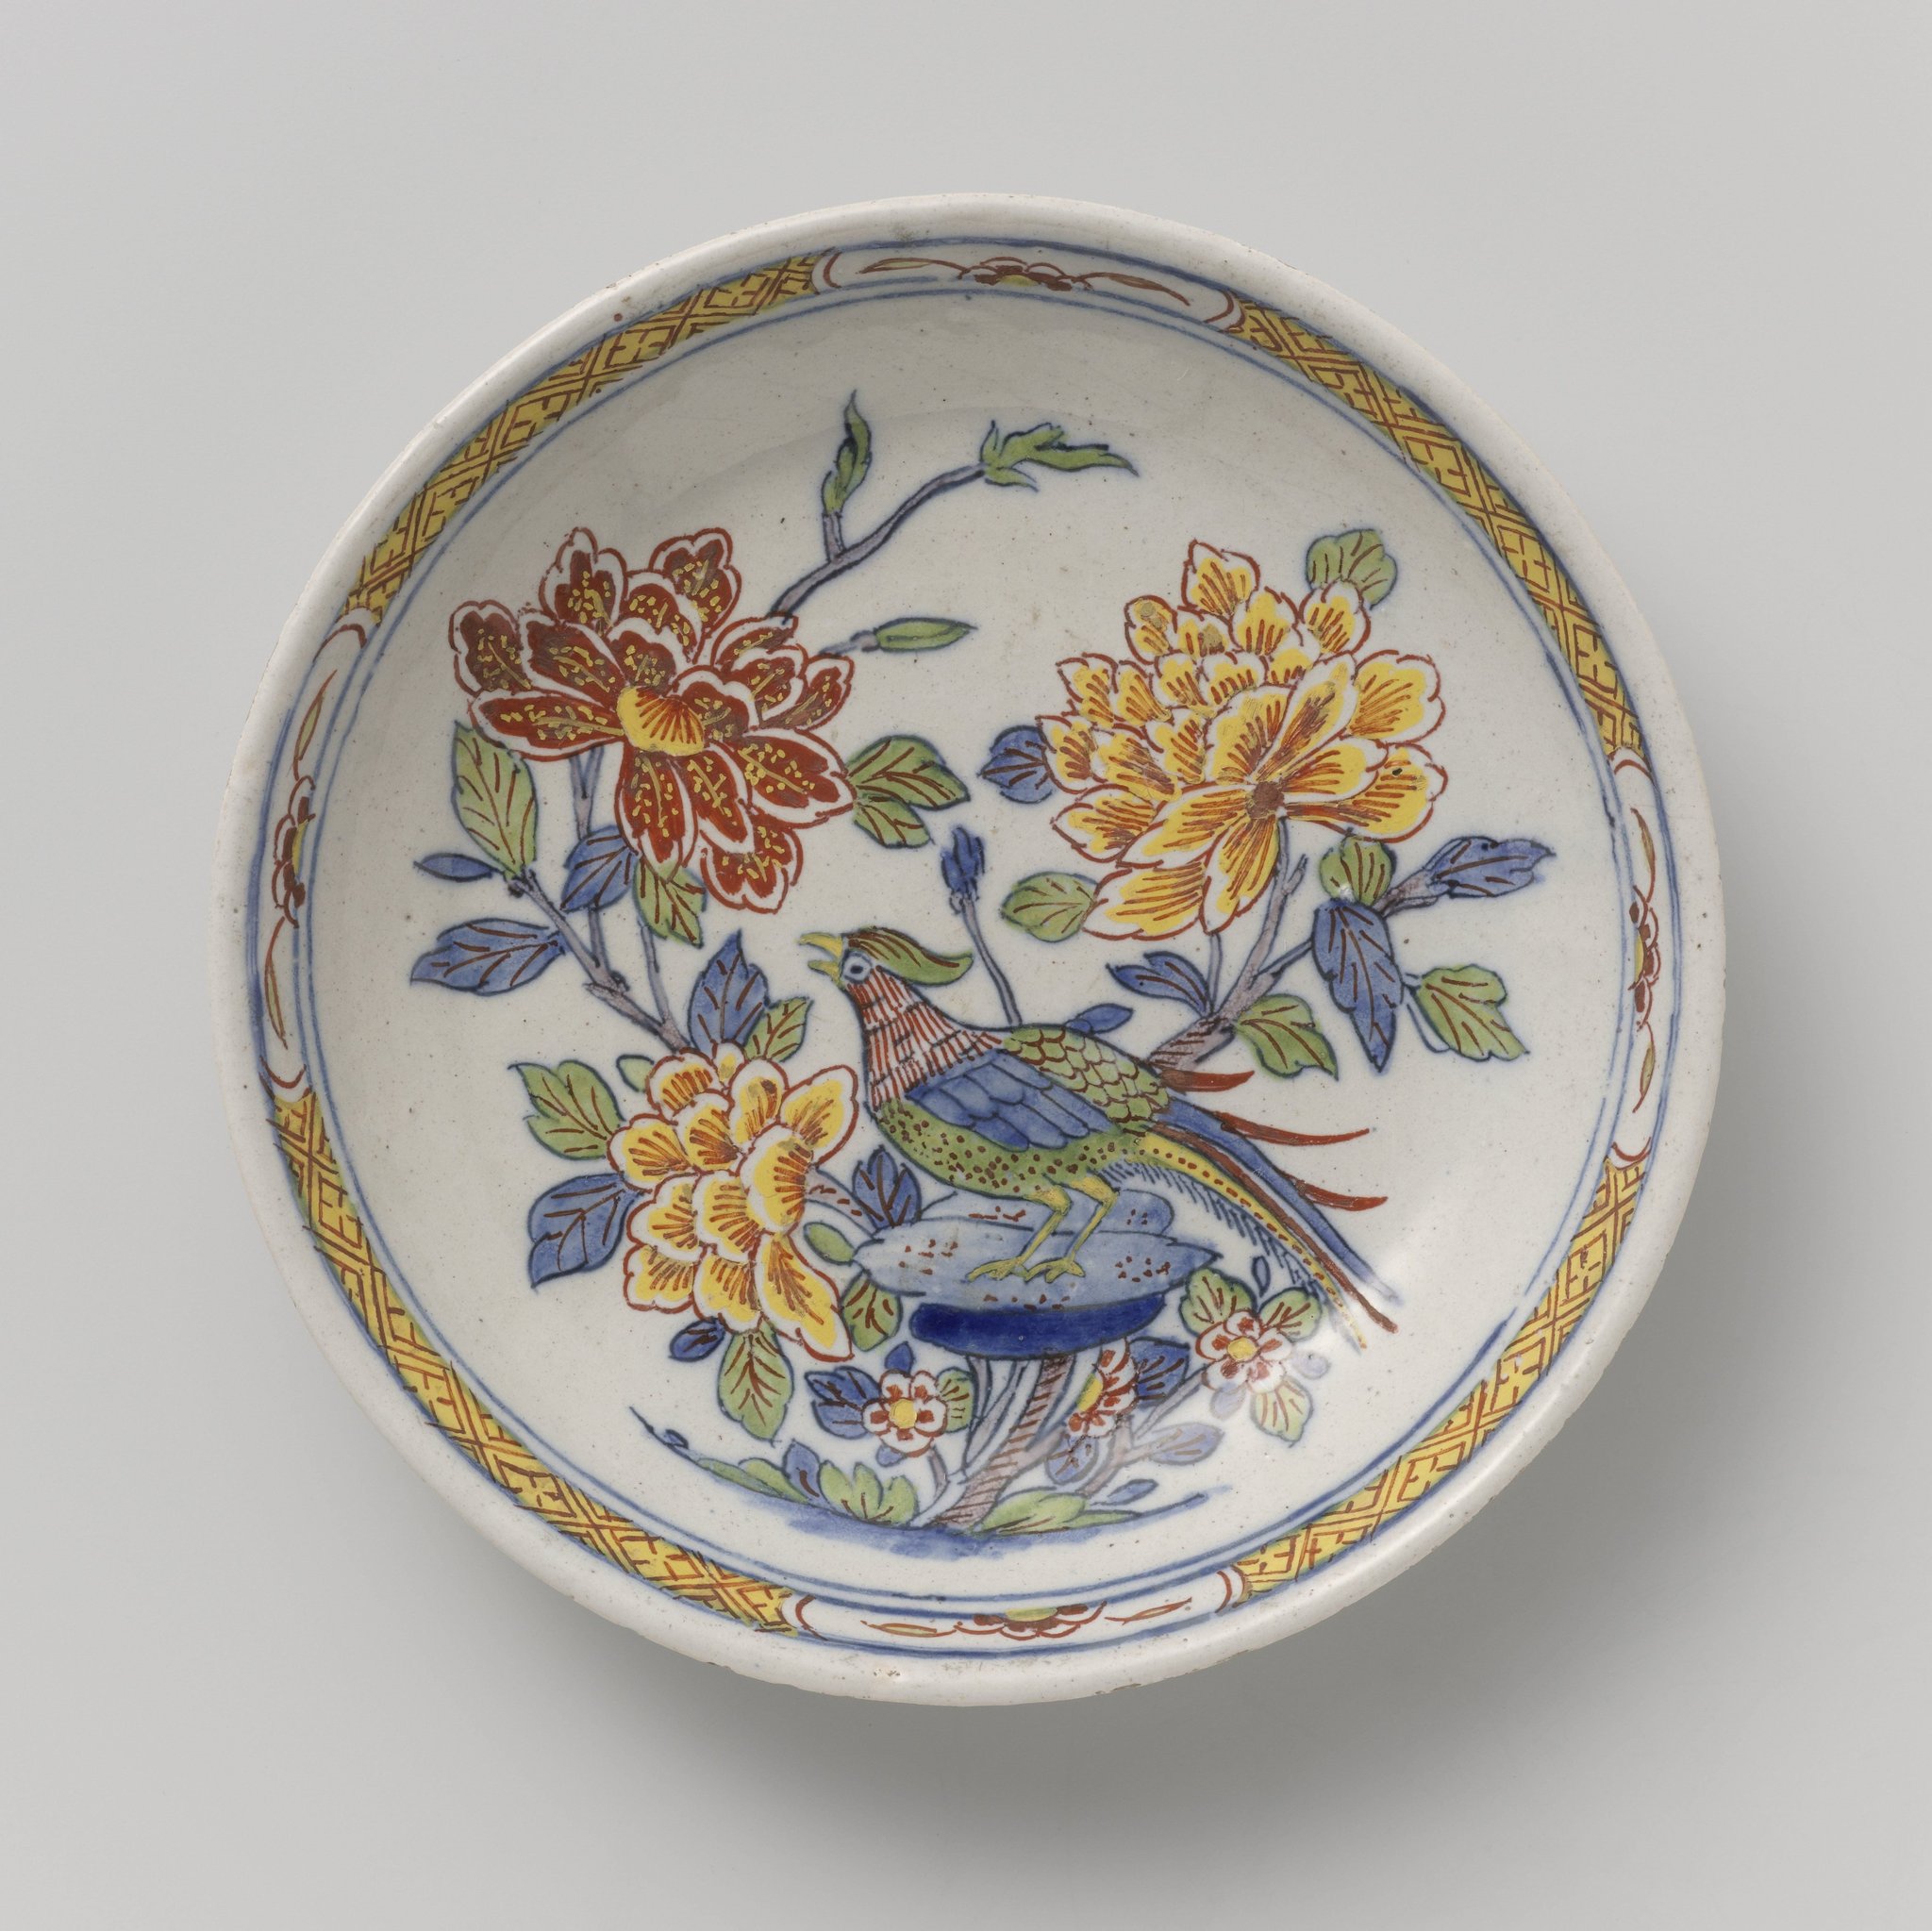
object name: platter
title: Schotel, beschilderd met bloemtakken en een vogel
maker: Anonymous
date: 1720-1740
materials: faience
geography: delft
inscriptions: label: ‘171’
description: Schotel van faience. Veelkleurig beschilderd met bloemtakken en een vogel.